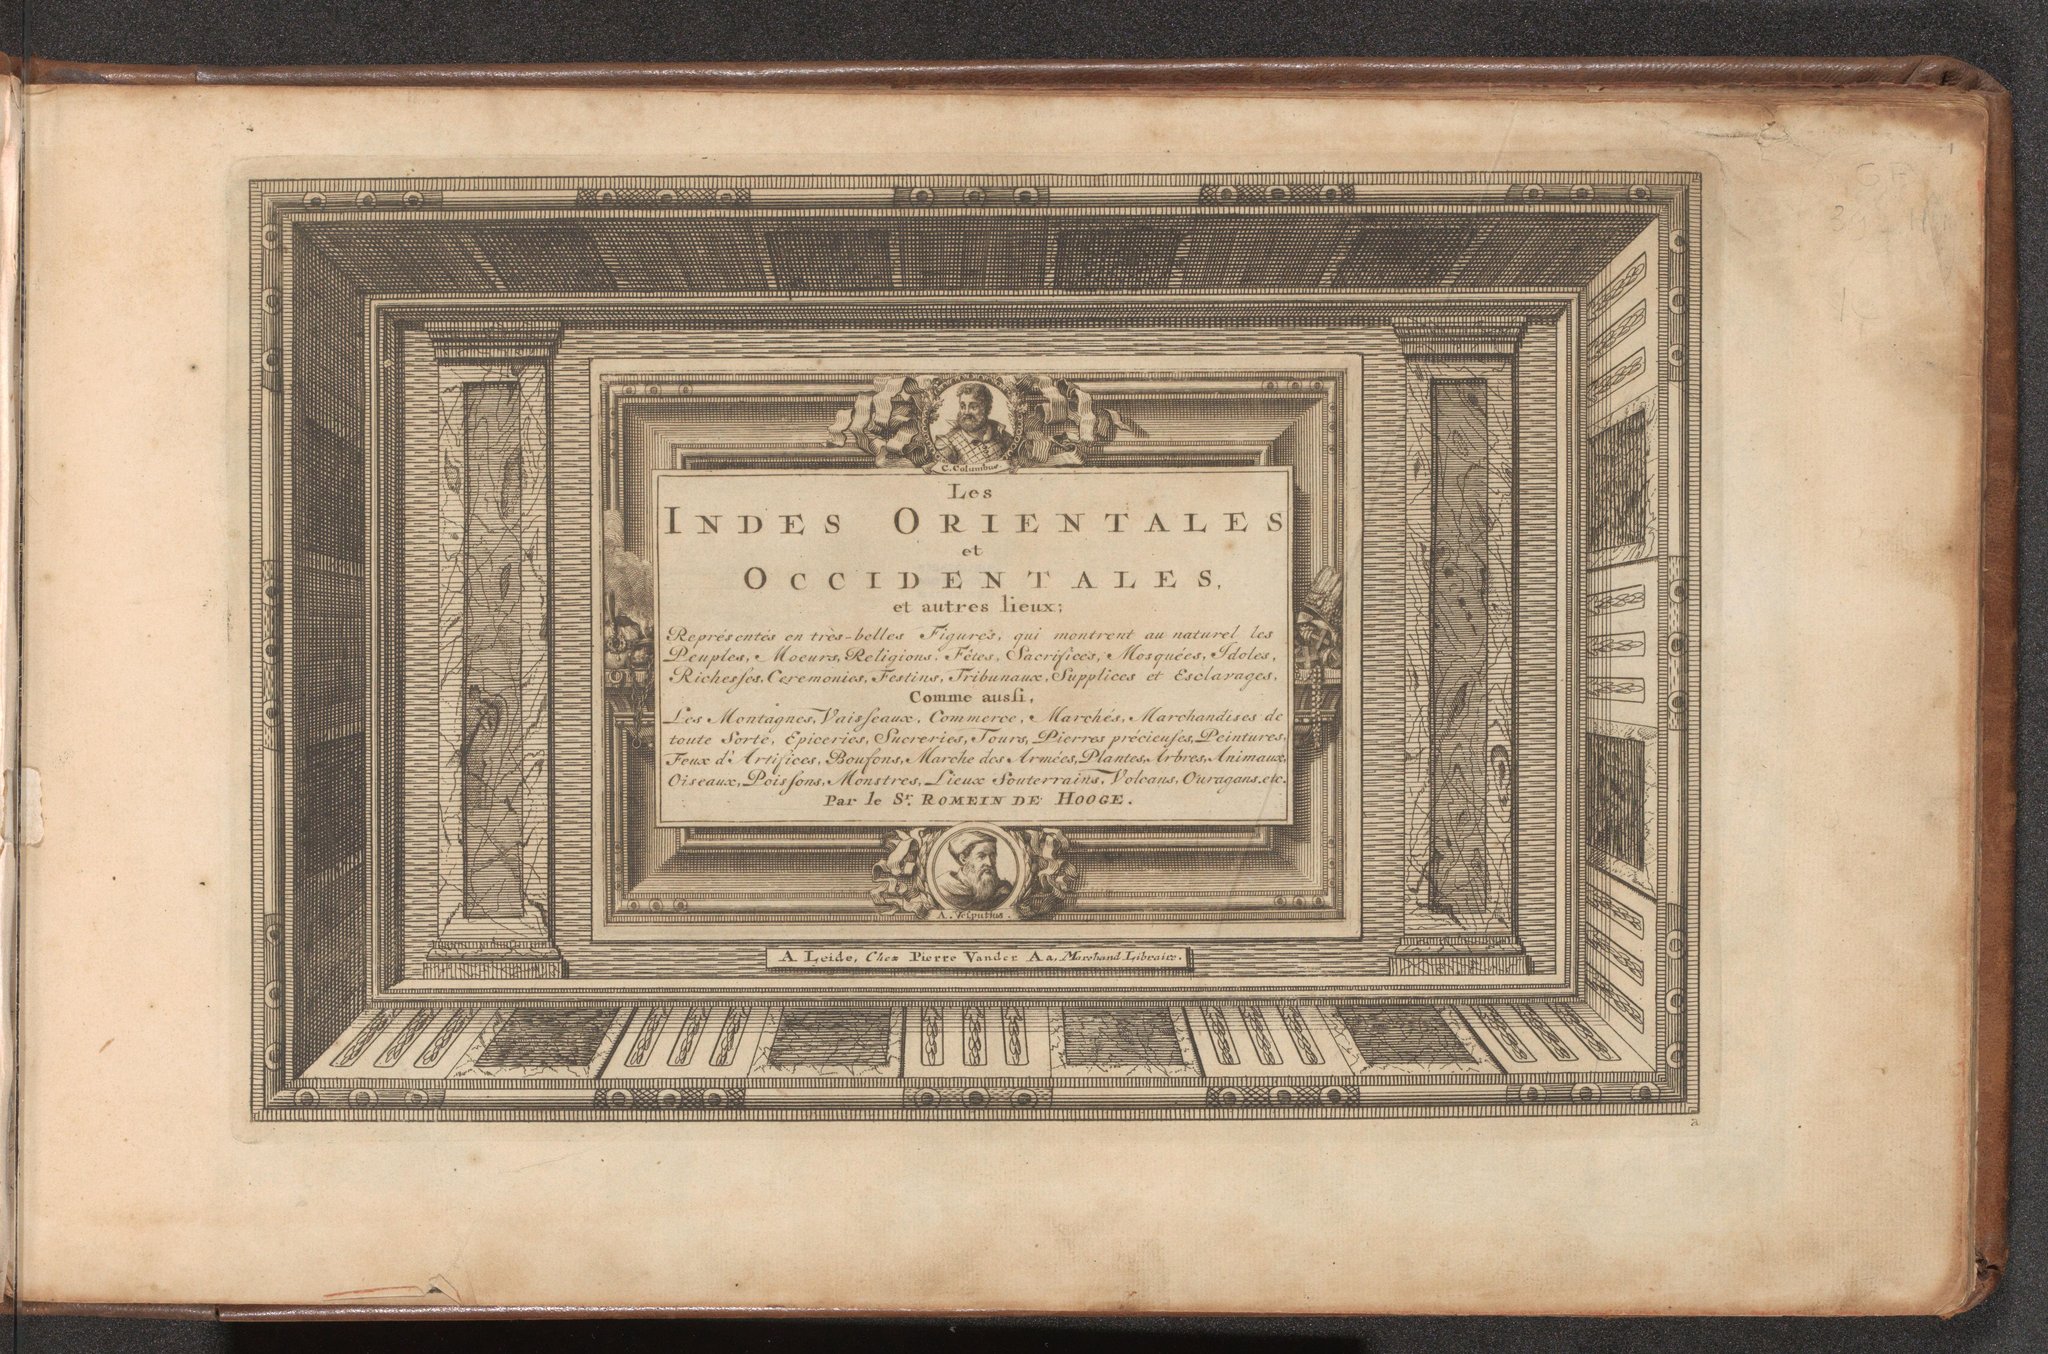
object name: titelprent, frontispice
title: Titelprent voor: Les Indes Orientales et Occidentales et autres lieux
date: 1669-1733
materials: paper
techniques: etching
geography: leiden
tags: title-page, half-column, pilaster ~ architecture, native peoples of the americas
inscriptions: collector's mark: ‘Bibliotheek Rijksmuseum Amsterdam’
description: Cartouche met de titel van de serie gevat in een op de architectuur gebaseerde omlijsting met pilasters. Boven en onder de cartouche een portret van respectievelijk Christoffel Columbus en Amerigo Vespucci. Links en rechts liggen op een console een tulband en een veren hoofdtooi met wierookvat. Rechtsonder: a. De prent maakt deel uit van een album.